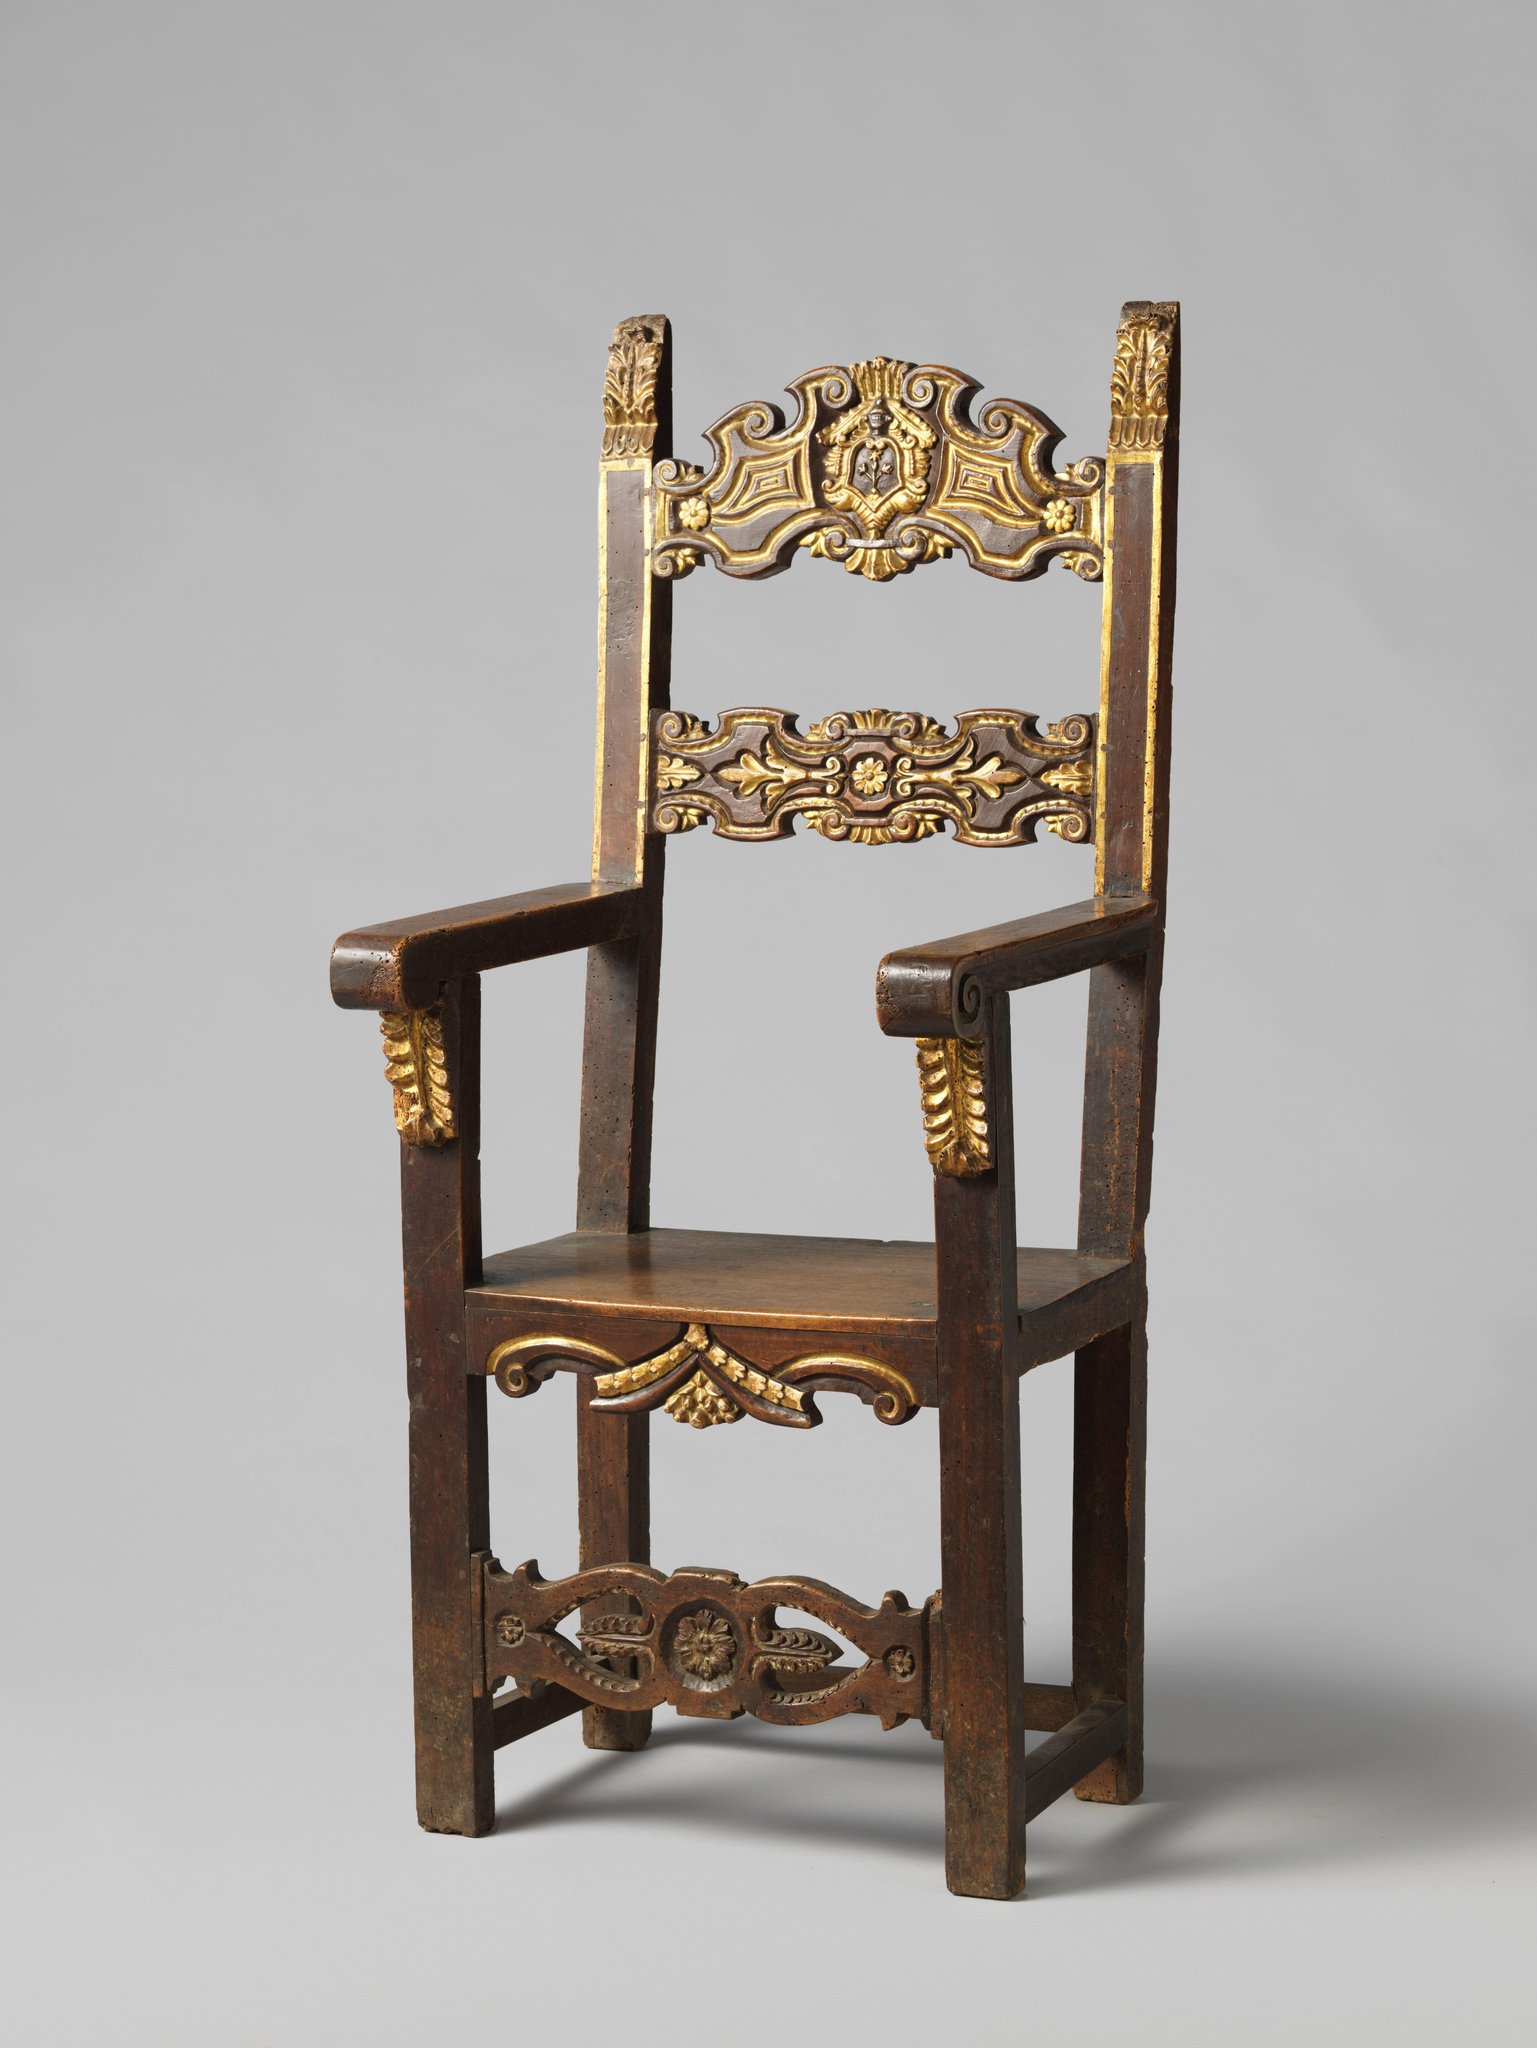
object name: armchair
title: Armstoel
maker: Anonymous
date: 1500-1600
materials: wood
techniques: gilding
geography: italy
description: Armstoel van notenhout, gedeeltelijk verguld. De voorpoten eindigen als stutten, die bovenaan met bladconsoles versierd zijn, en die de armleggers, eindigend in voluten, steunen. De uitgezaagde voorsport, voorzitregel en rugsporten zijn versierd met ondermeer gestoken bladmotieven, rozetten en voluten. De rugstijlen, bekroond met bladmotieven, hellen achterwaarts. De bovensport van de rug draagt een wapenschild met bloemen, kogels en ster. De poten zijn vierkant. Zie tevens BK-16646-b/d.